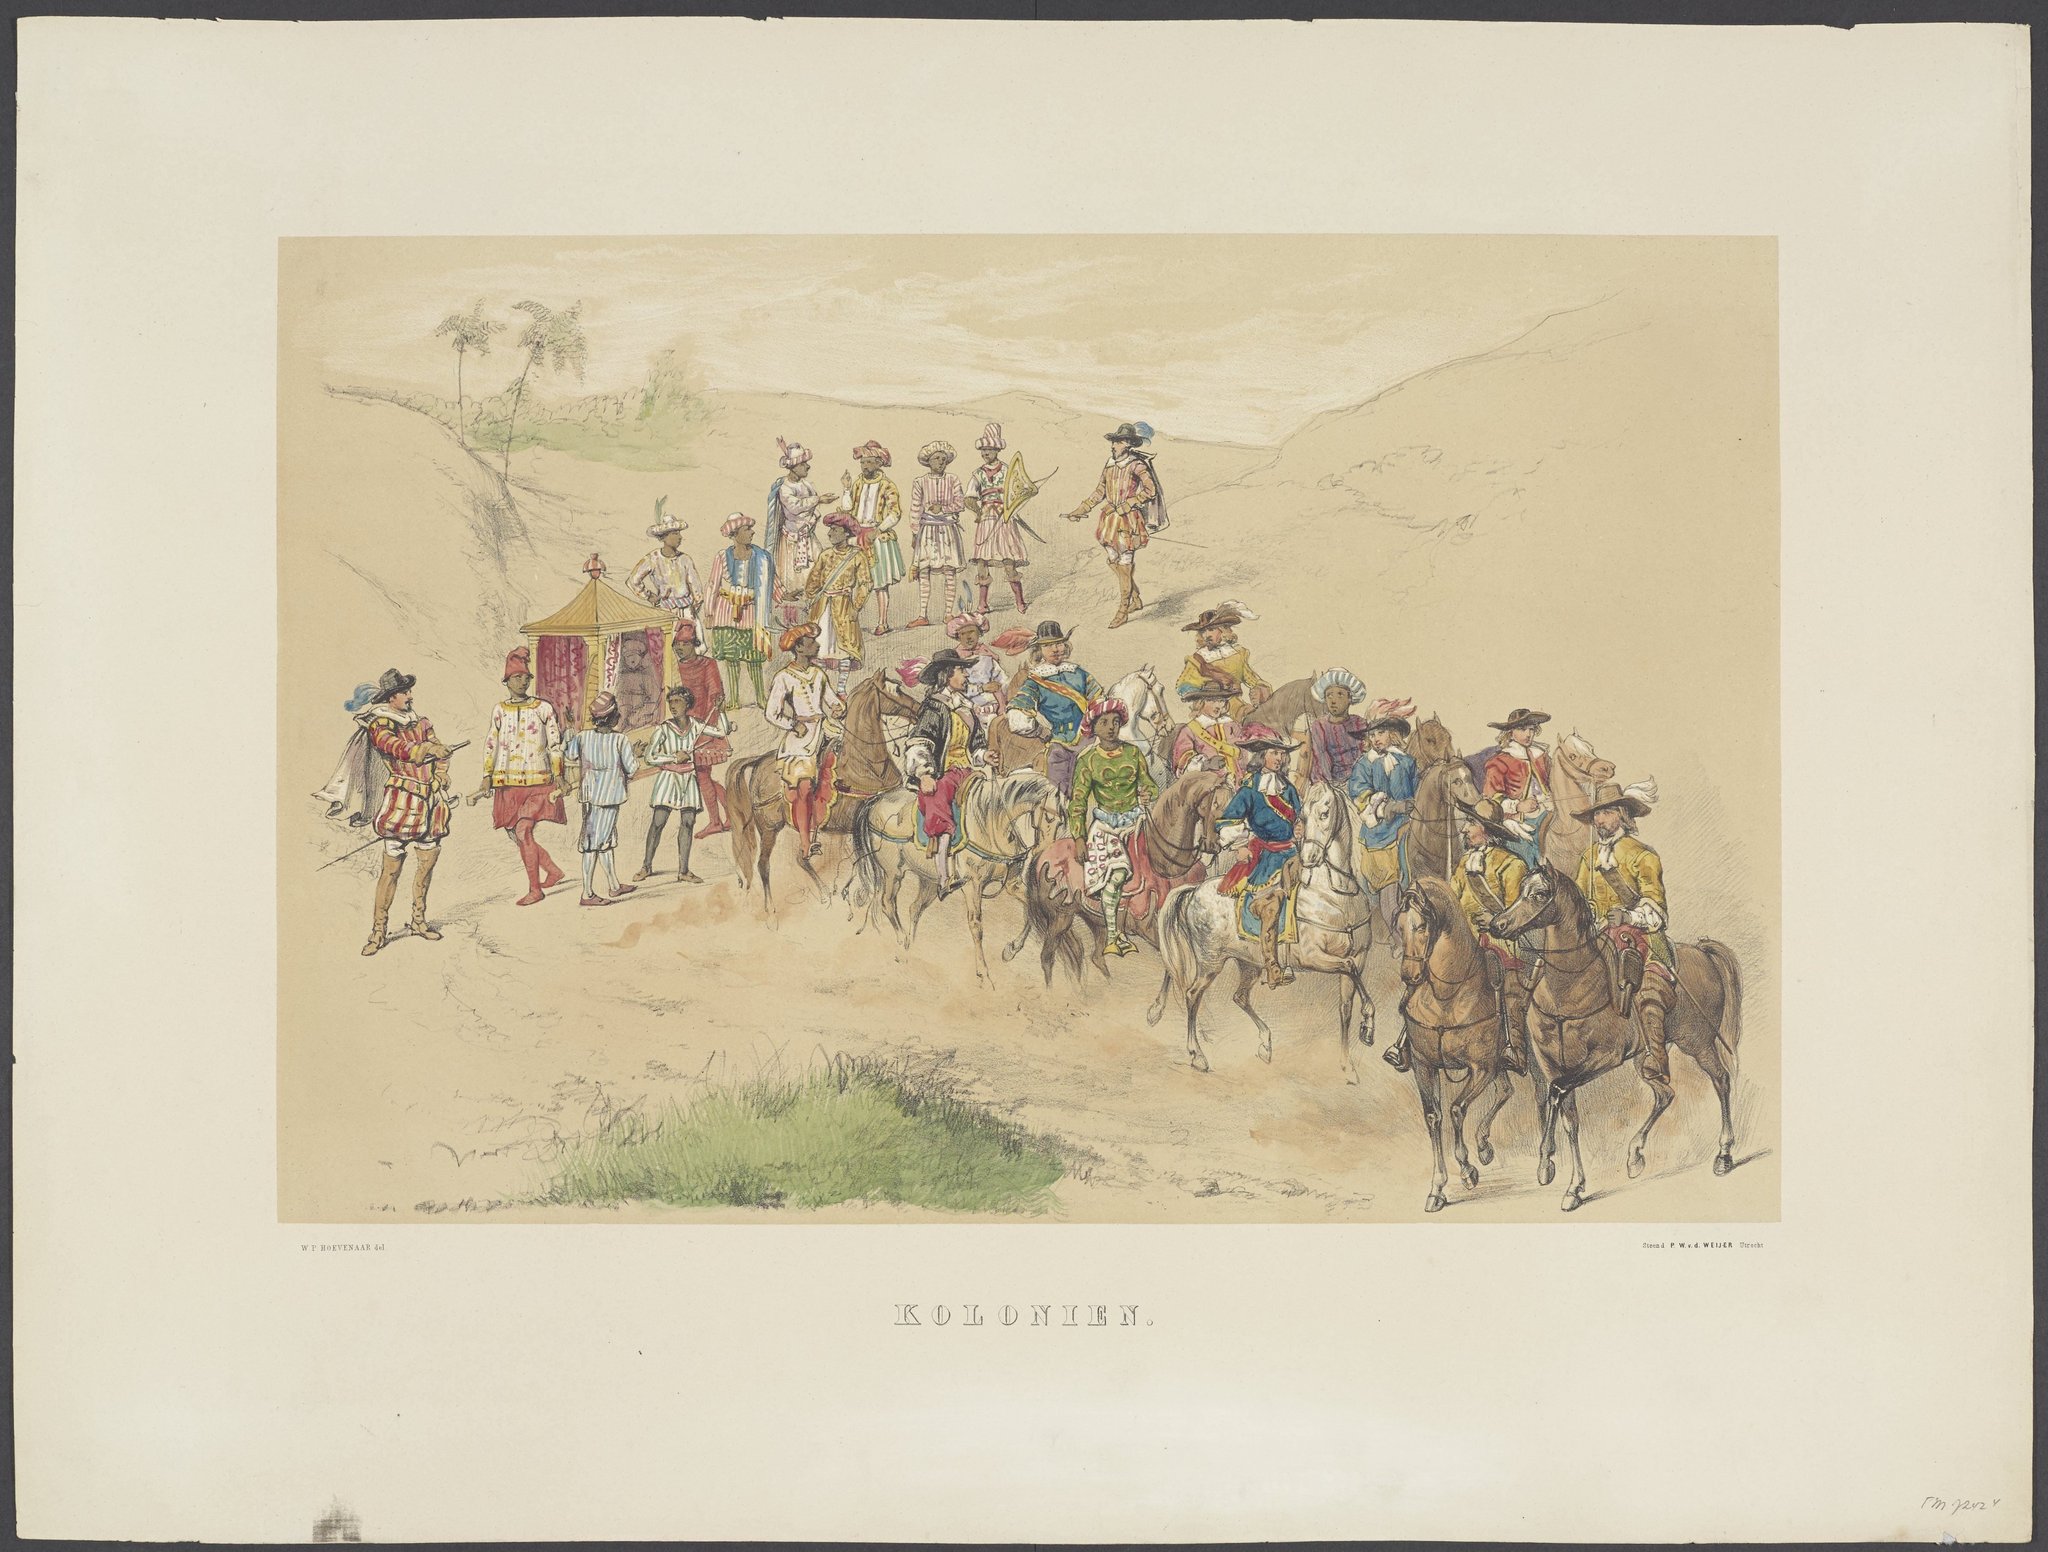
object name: print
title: Utrechtse maskerade van 1856, plaat 4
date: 1856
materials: paper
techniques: hand coloring, lithograph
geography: netherlands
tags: students' pageant, costumes used in pageants, dutch east indies, the, utrecht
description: Een stoet van Nederlandse ruiters, Javaanse prinsen, Bengaalse radja's en hun afgezanten. Onderdeel van de groep van zeven platen met verklaring van de historische optocht in maskerade opgevoerd door de studenten van de vereniging Mutua Fides van de Utrechtse Hogeschool op 25 juni 1856 ter gelegenheid van de viering van haar 220-jarige bestaan.